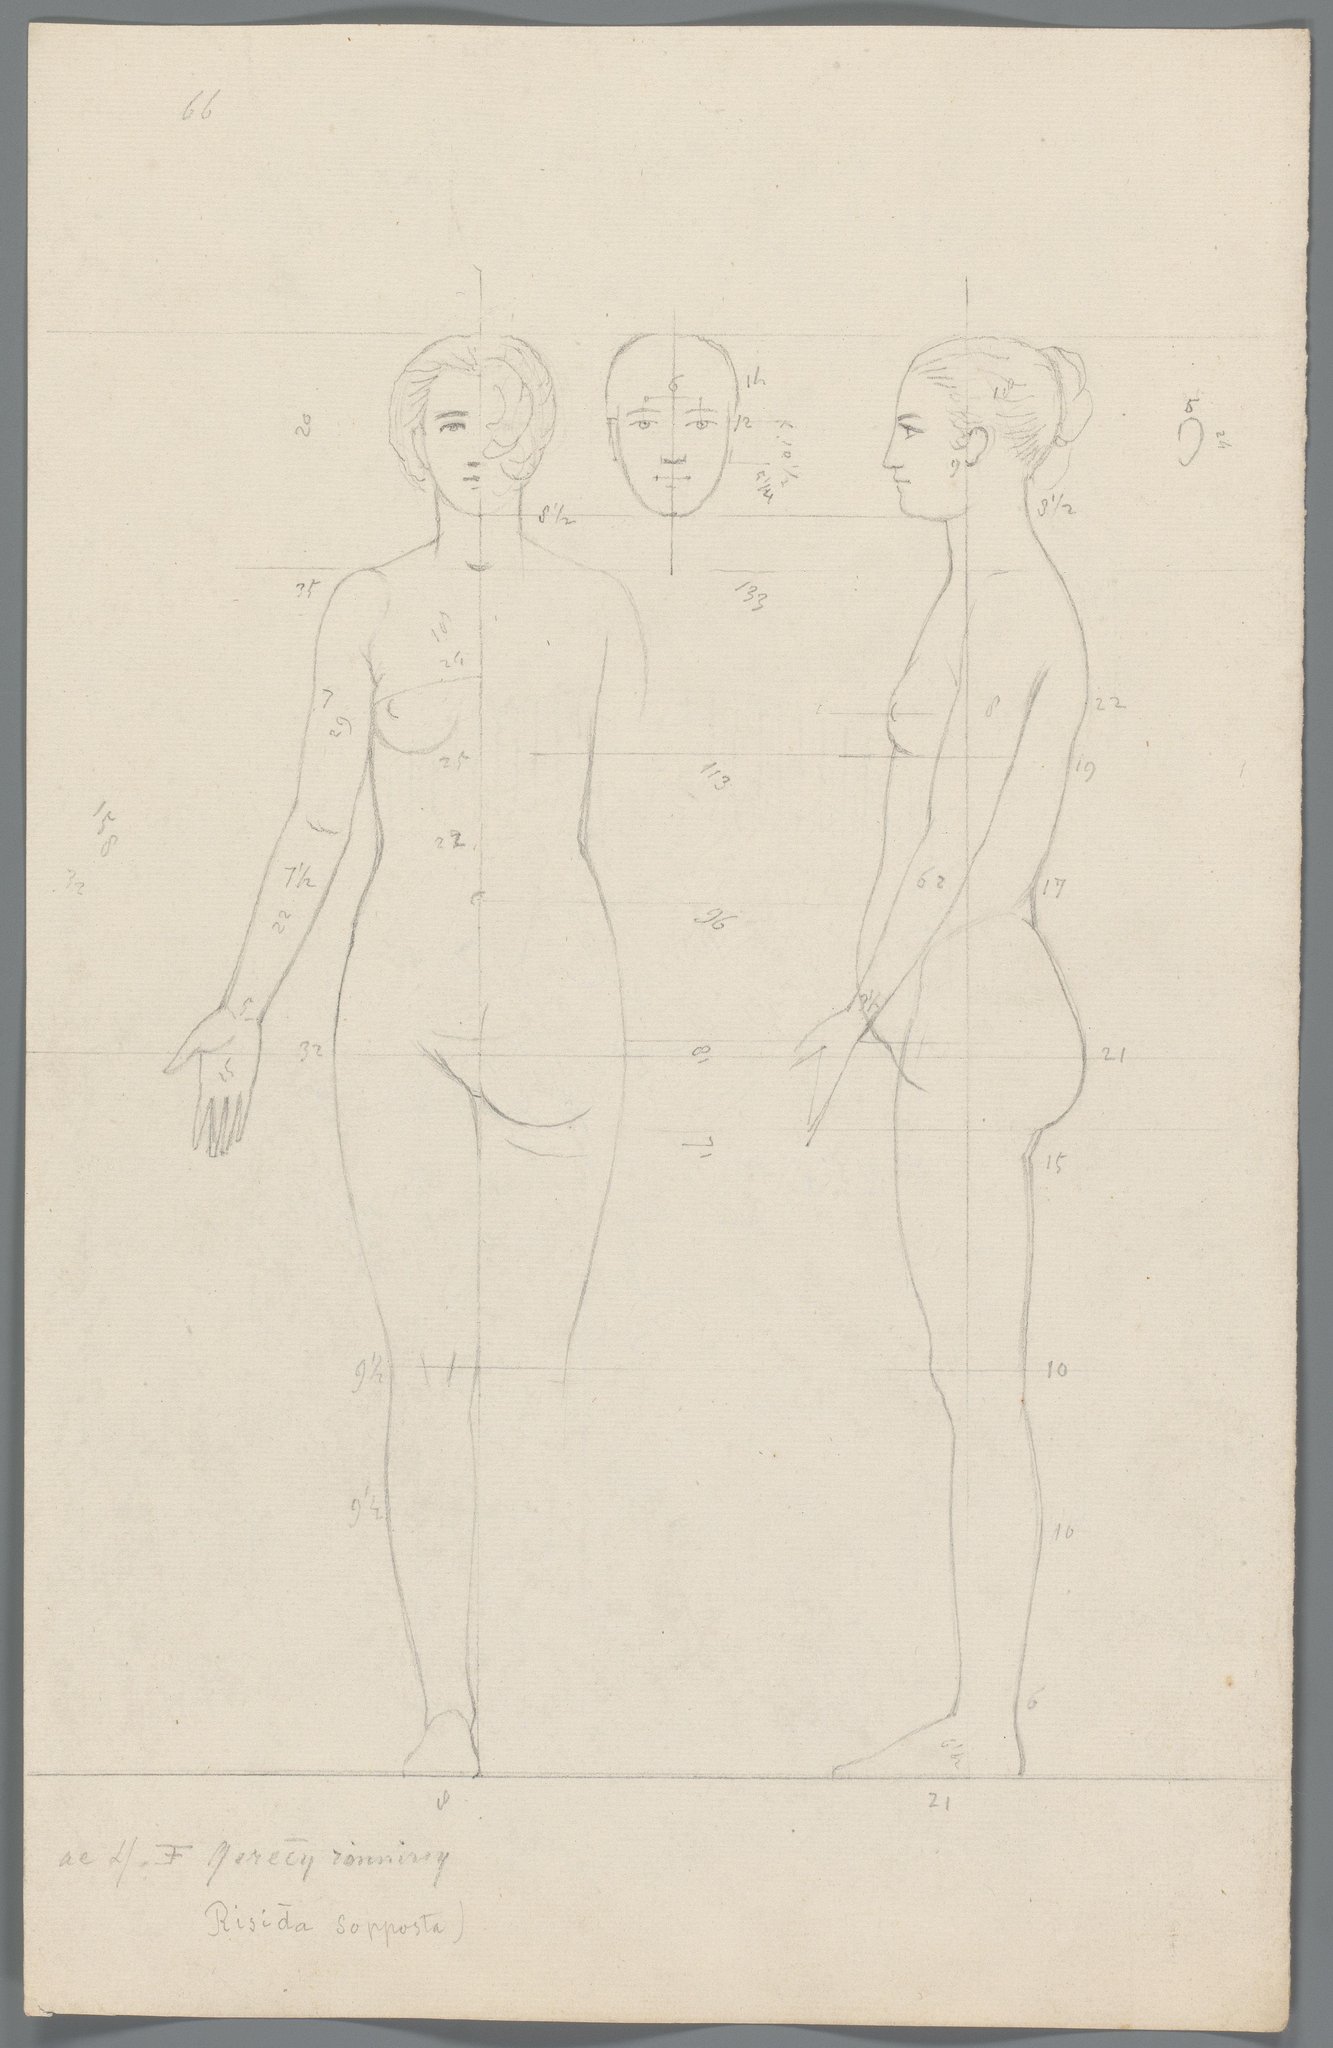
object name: drawing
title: Proportiestudie van een vrouw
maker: jacobus everhardus josephus van den berg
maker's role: draughtsman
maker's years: 1802-1861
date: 1856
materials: paper, pencil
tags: standing figure (canon, proportions) - aa - female human figure, anatomy (non-medical) - aa - female human figure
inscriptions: inscription: ‘ae [...] EF [...]/ Risida sopposta’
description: Voor-, achter- en zijaanzicht, met een detail van het hoofd.